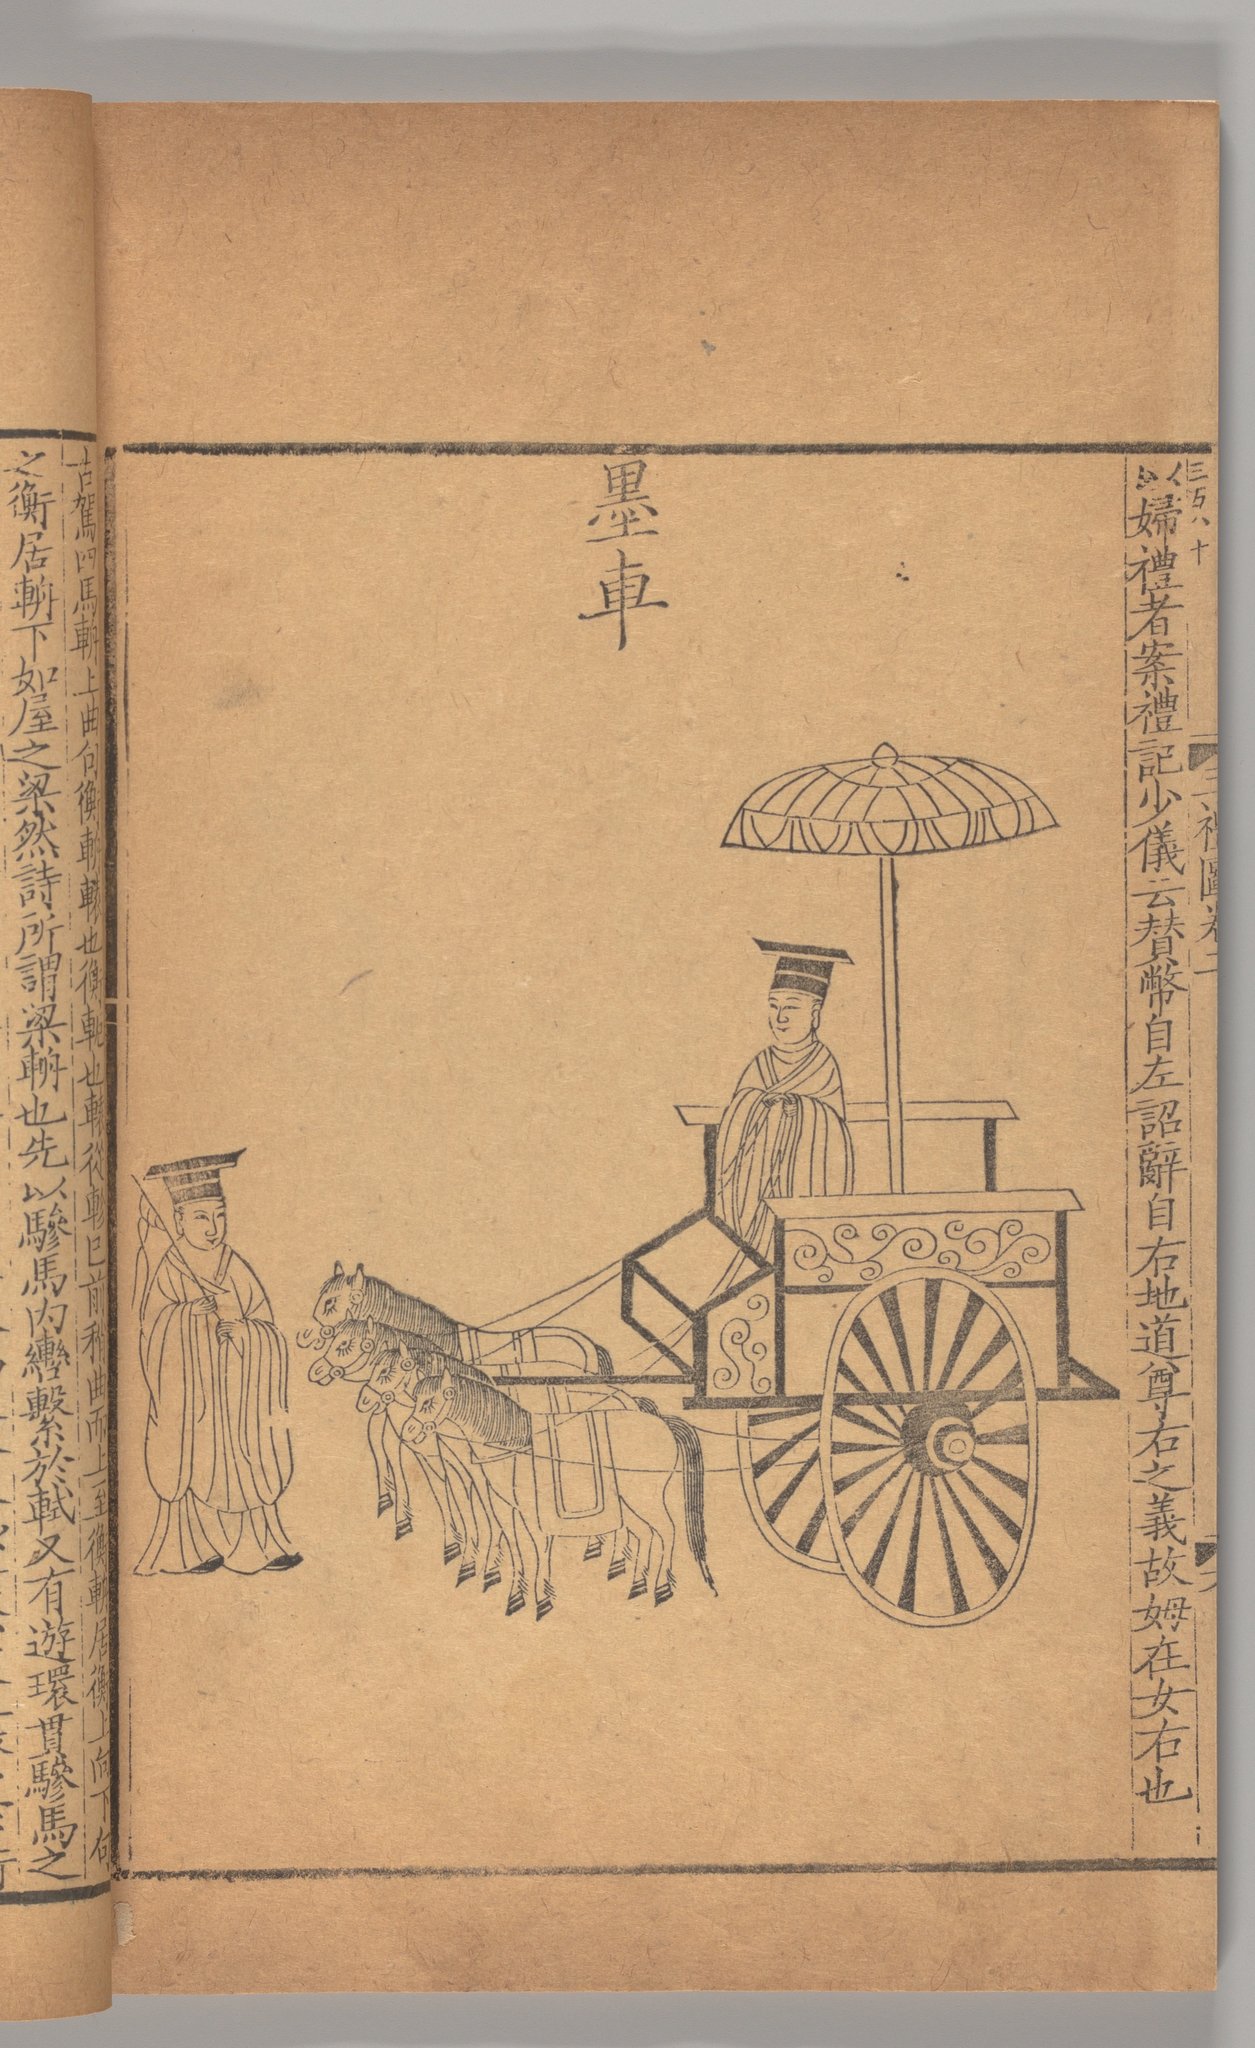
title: San li tu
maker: chongyi nie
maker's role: author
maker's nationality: chinese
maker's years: 900-999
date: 1676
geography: china